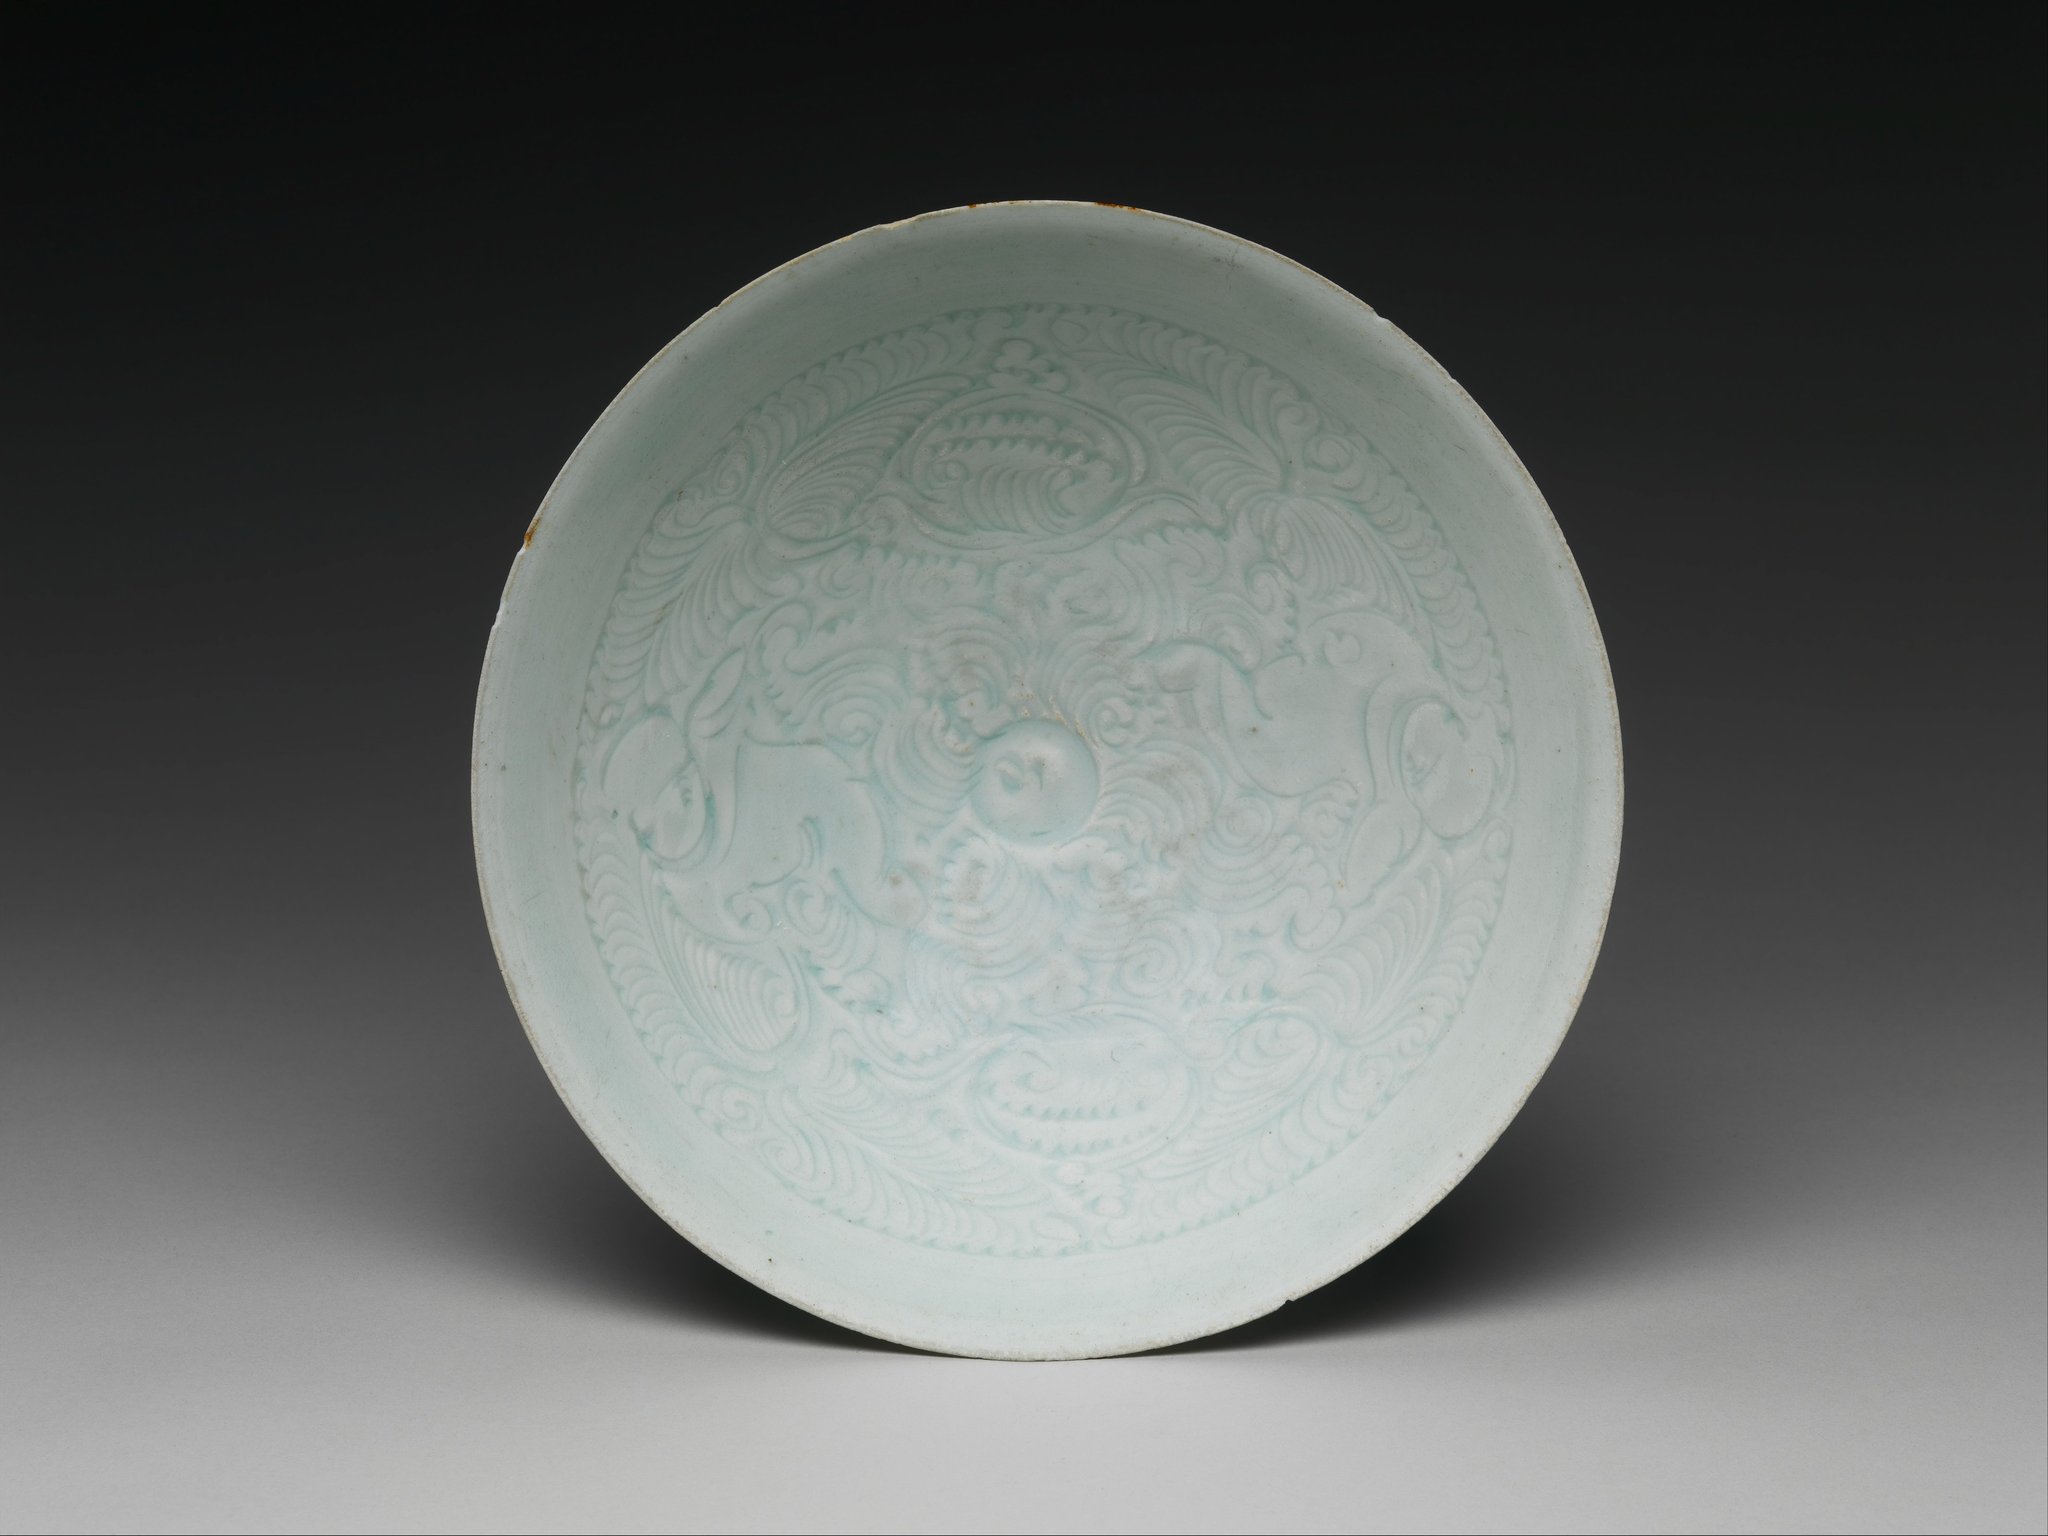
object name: bowl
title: Bowl with two boys and foliage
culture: chinese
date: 1101-1300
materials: glaze, porcelain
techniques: incising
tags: boys,leaves